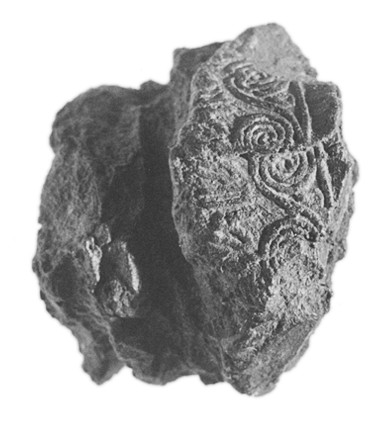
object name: sealing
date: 2030-1640 BCE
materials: clay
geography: egypt